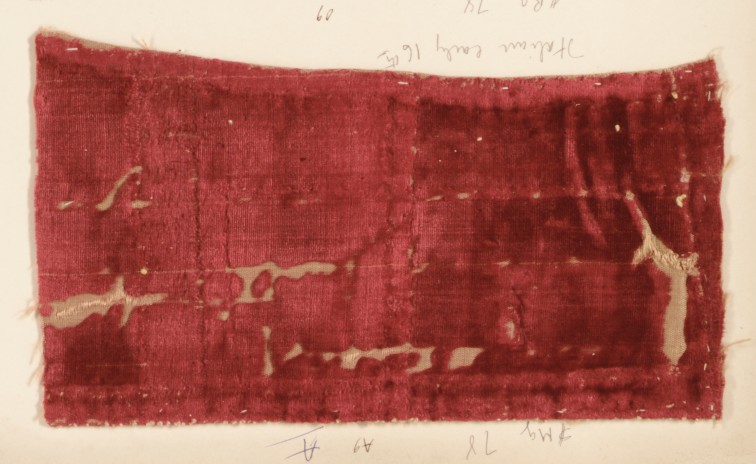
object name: fragment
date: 1501-1533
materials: silk